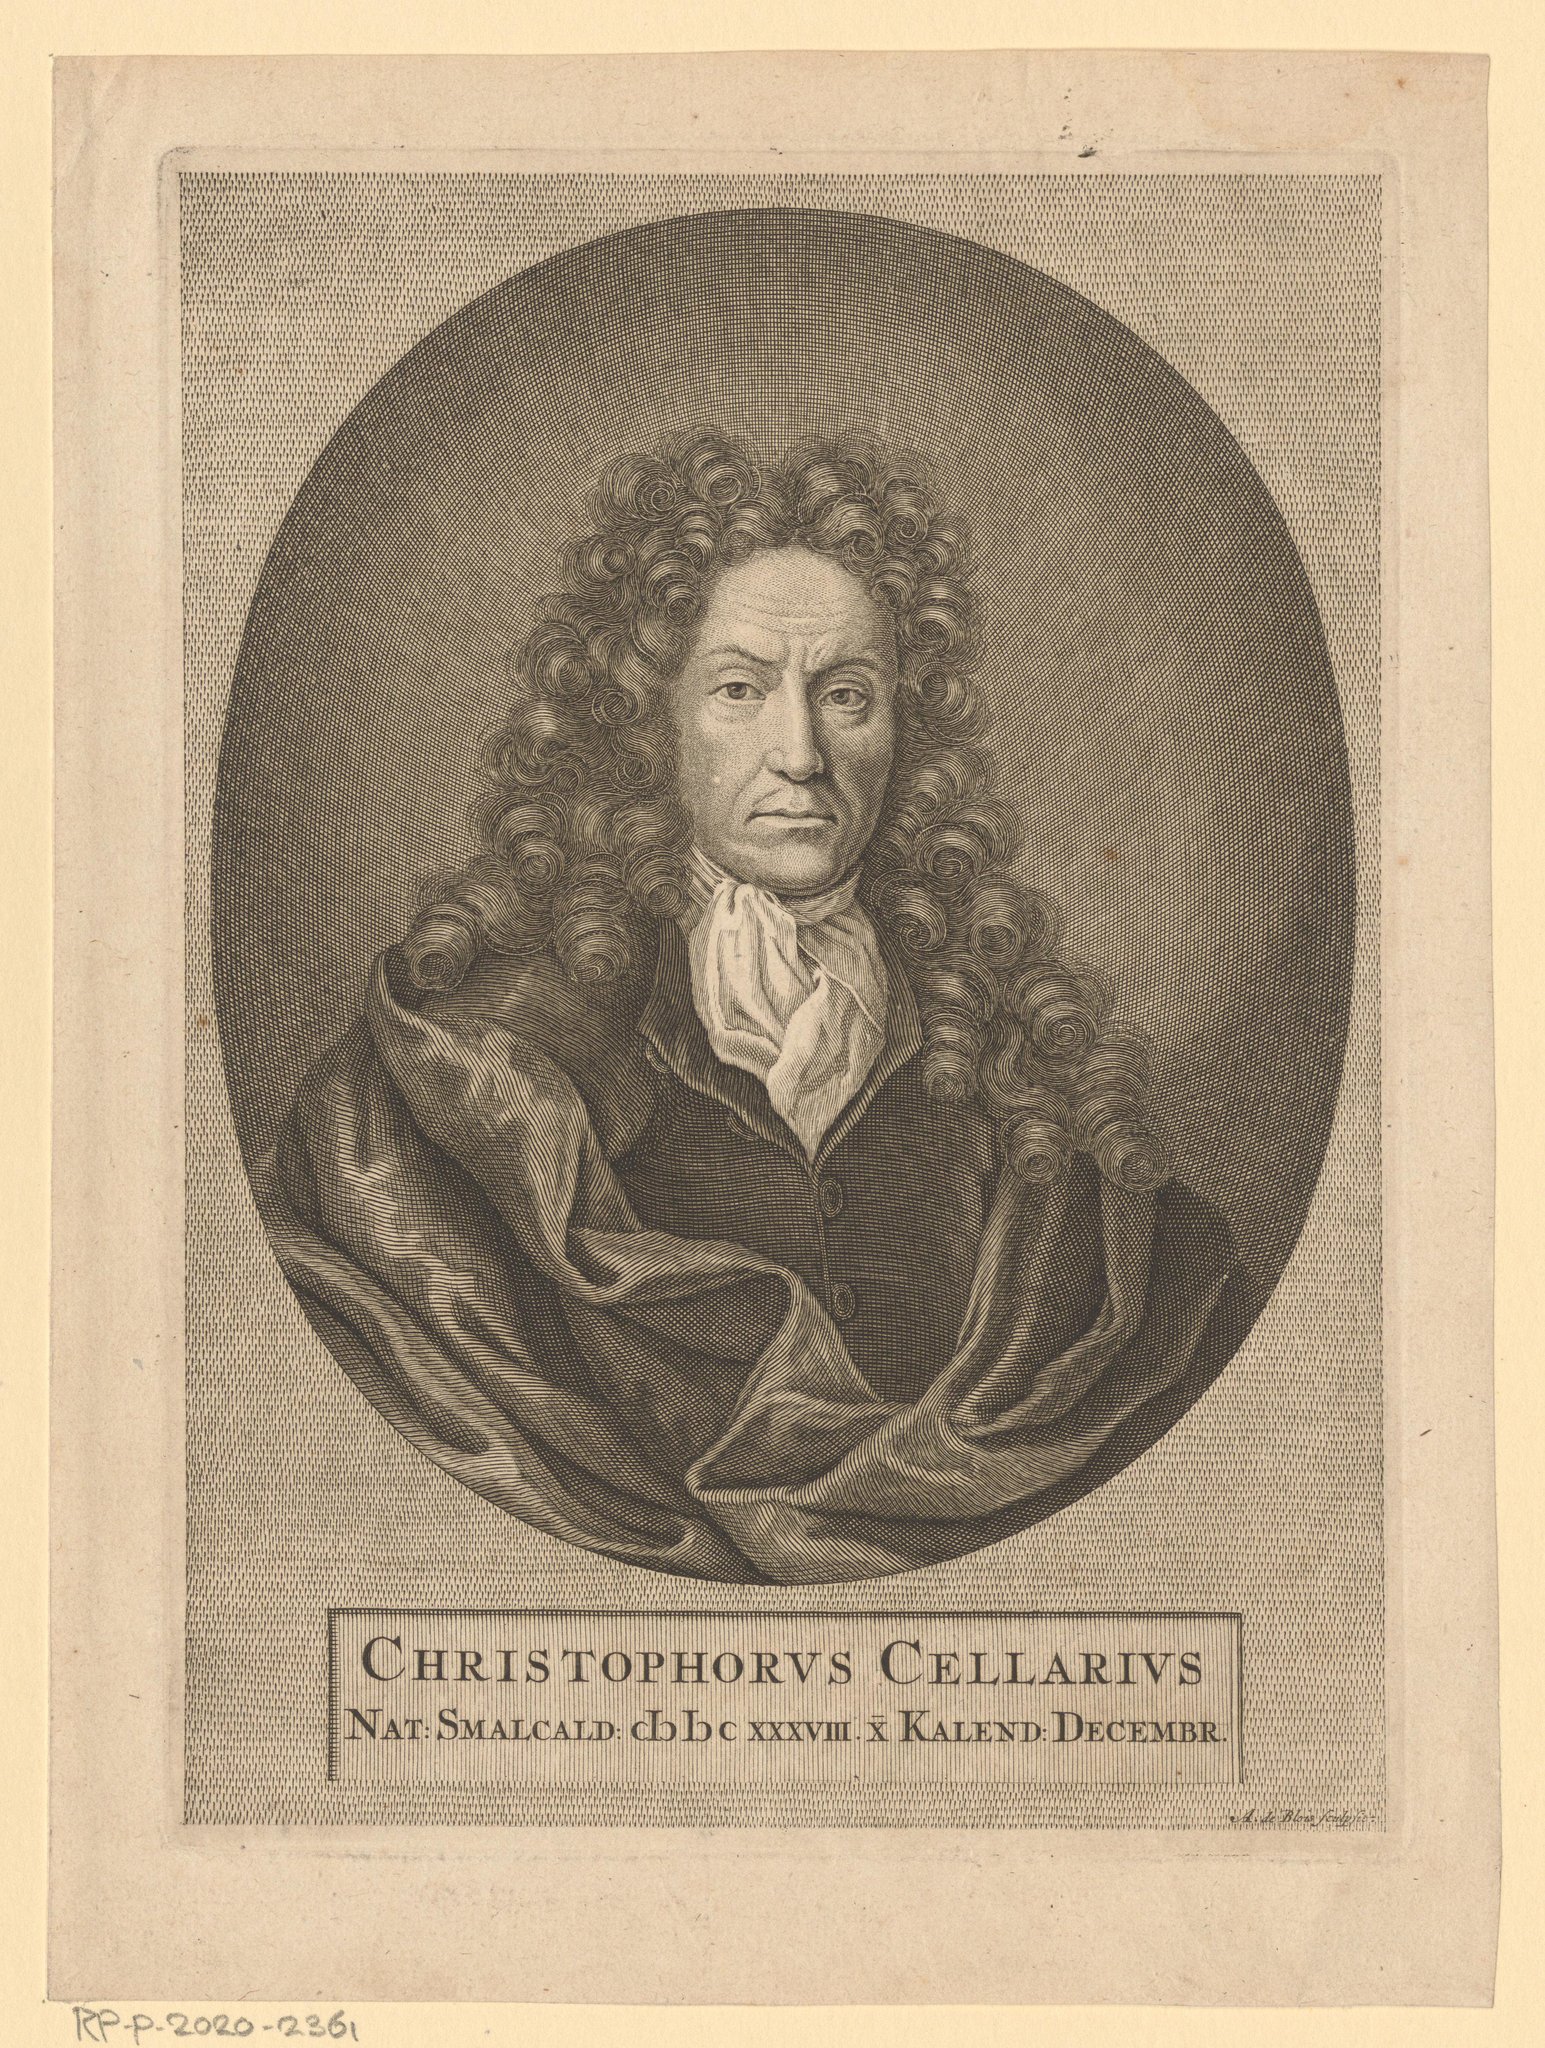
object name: print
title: Portret van Christoph Cellarius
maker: abraham de blois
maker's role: print maker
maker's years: 1679-1717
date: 1689-1717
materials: paper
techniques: engraving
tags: historical persons